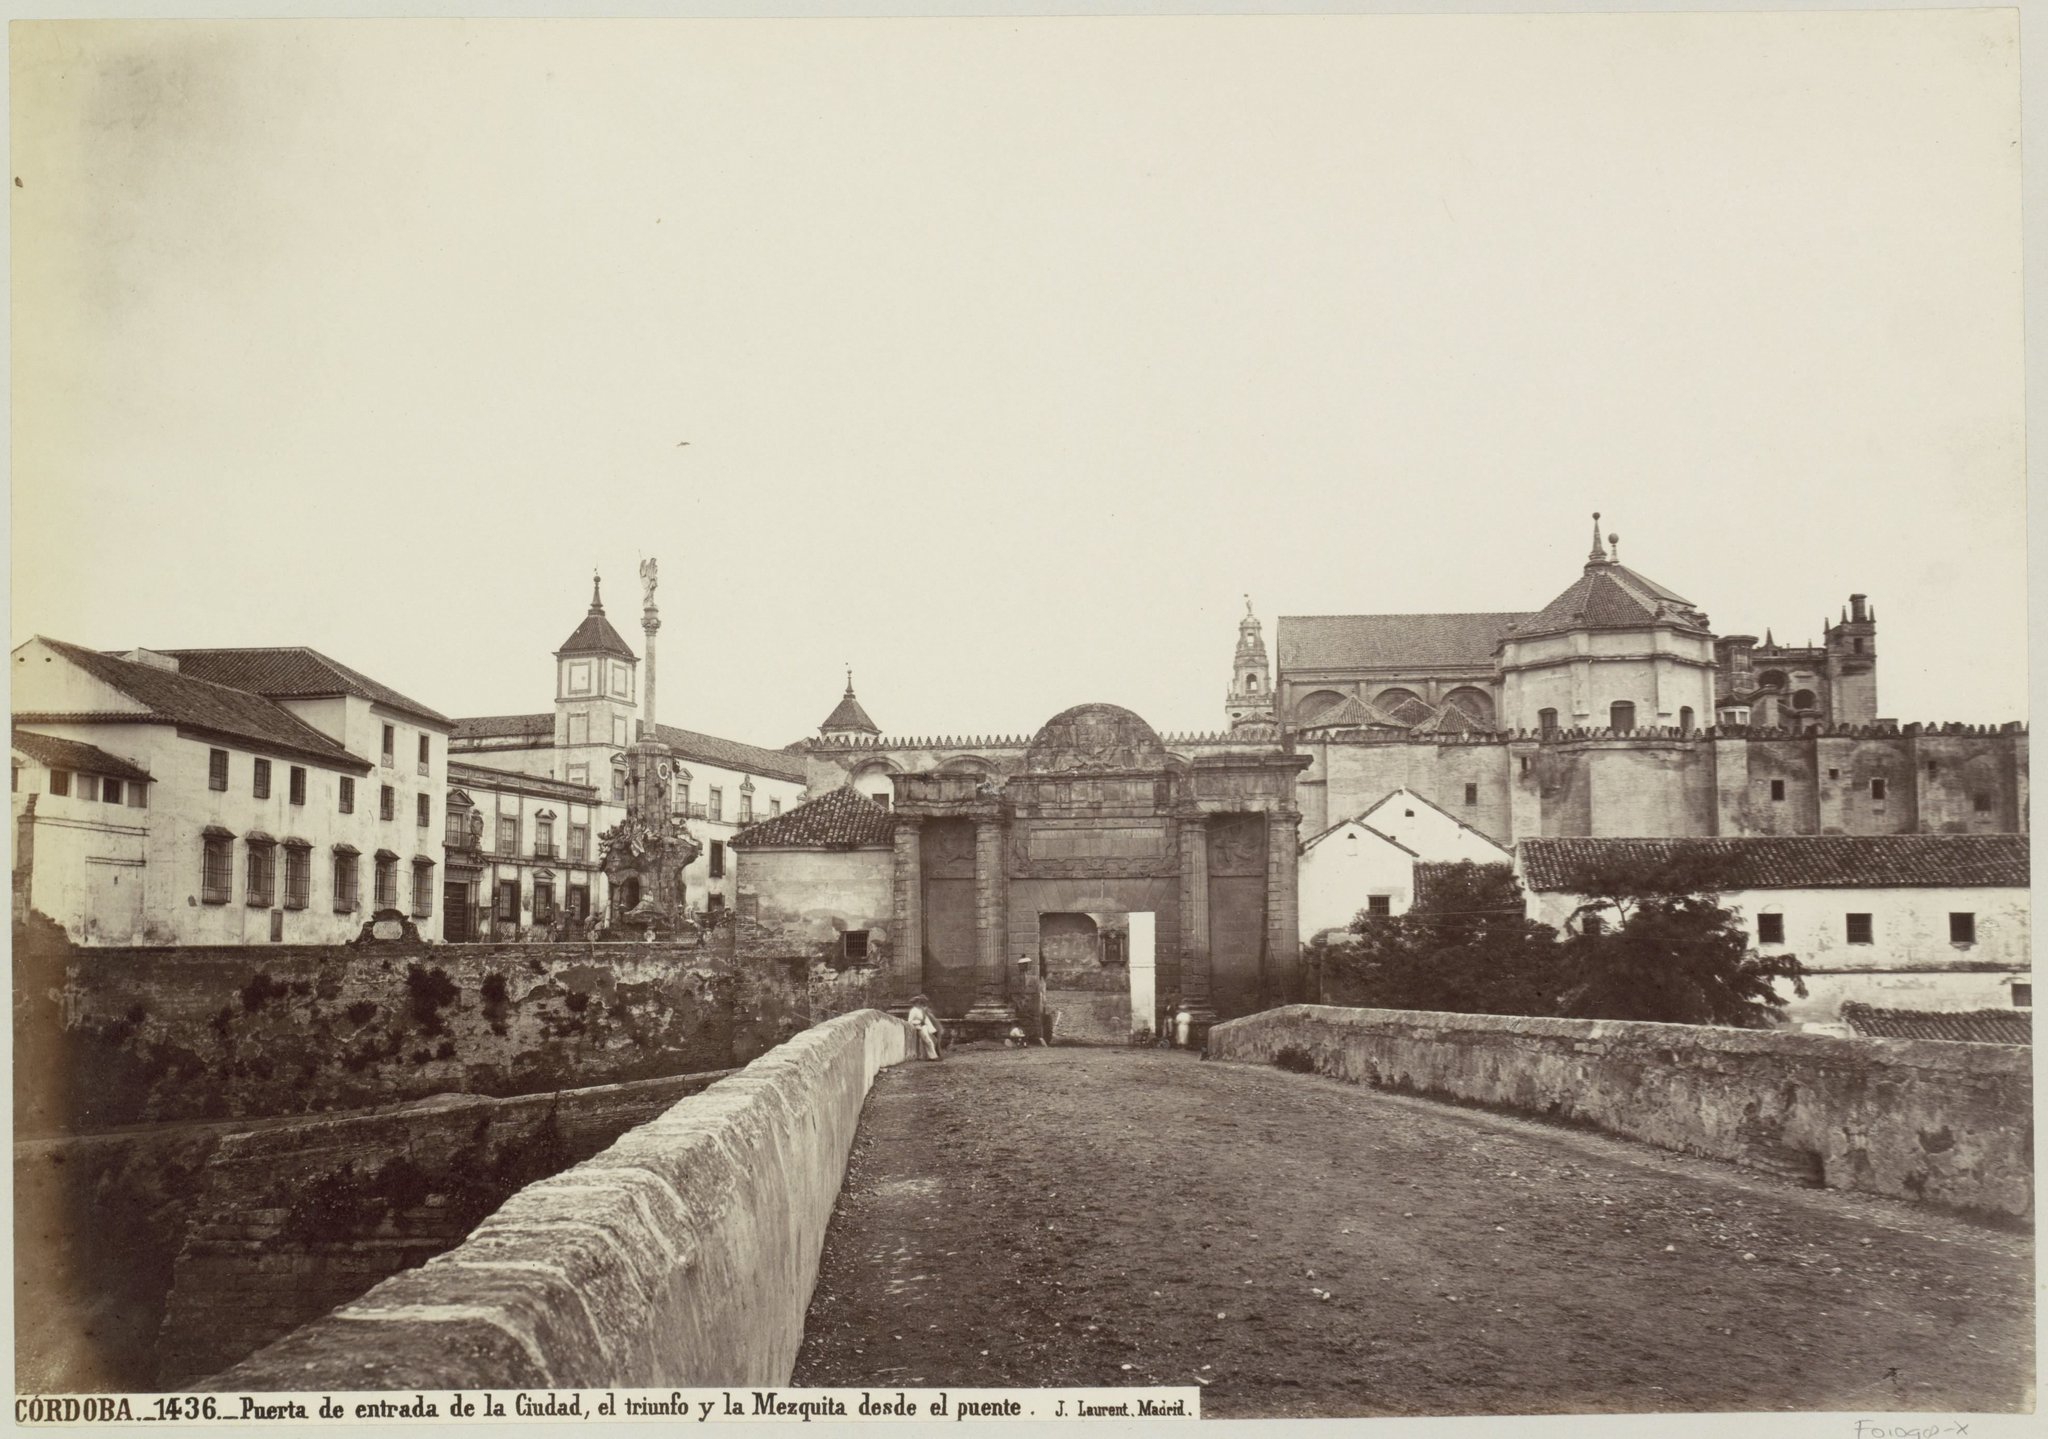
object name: photograph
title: Gezicht op Puerta del Puente in Córdoba met links de Triunfo de San Rafael en rechts de kathedraal (Mezquita)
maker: juan laurent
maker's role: publisher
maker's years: 1816-1896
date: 1857-1880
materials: cardboard, paper, photographic support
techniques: albumen print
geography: córdoba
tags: column, pillar ~ architecture, church (exterior), city-gate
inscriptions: negative number: ‘1436’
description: Onderdeel van Reisalbum met foto's van bezienswaardigheden in Spanje en Marokko.